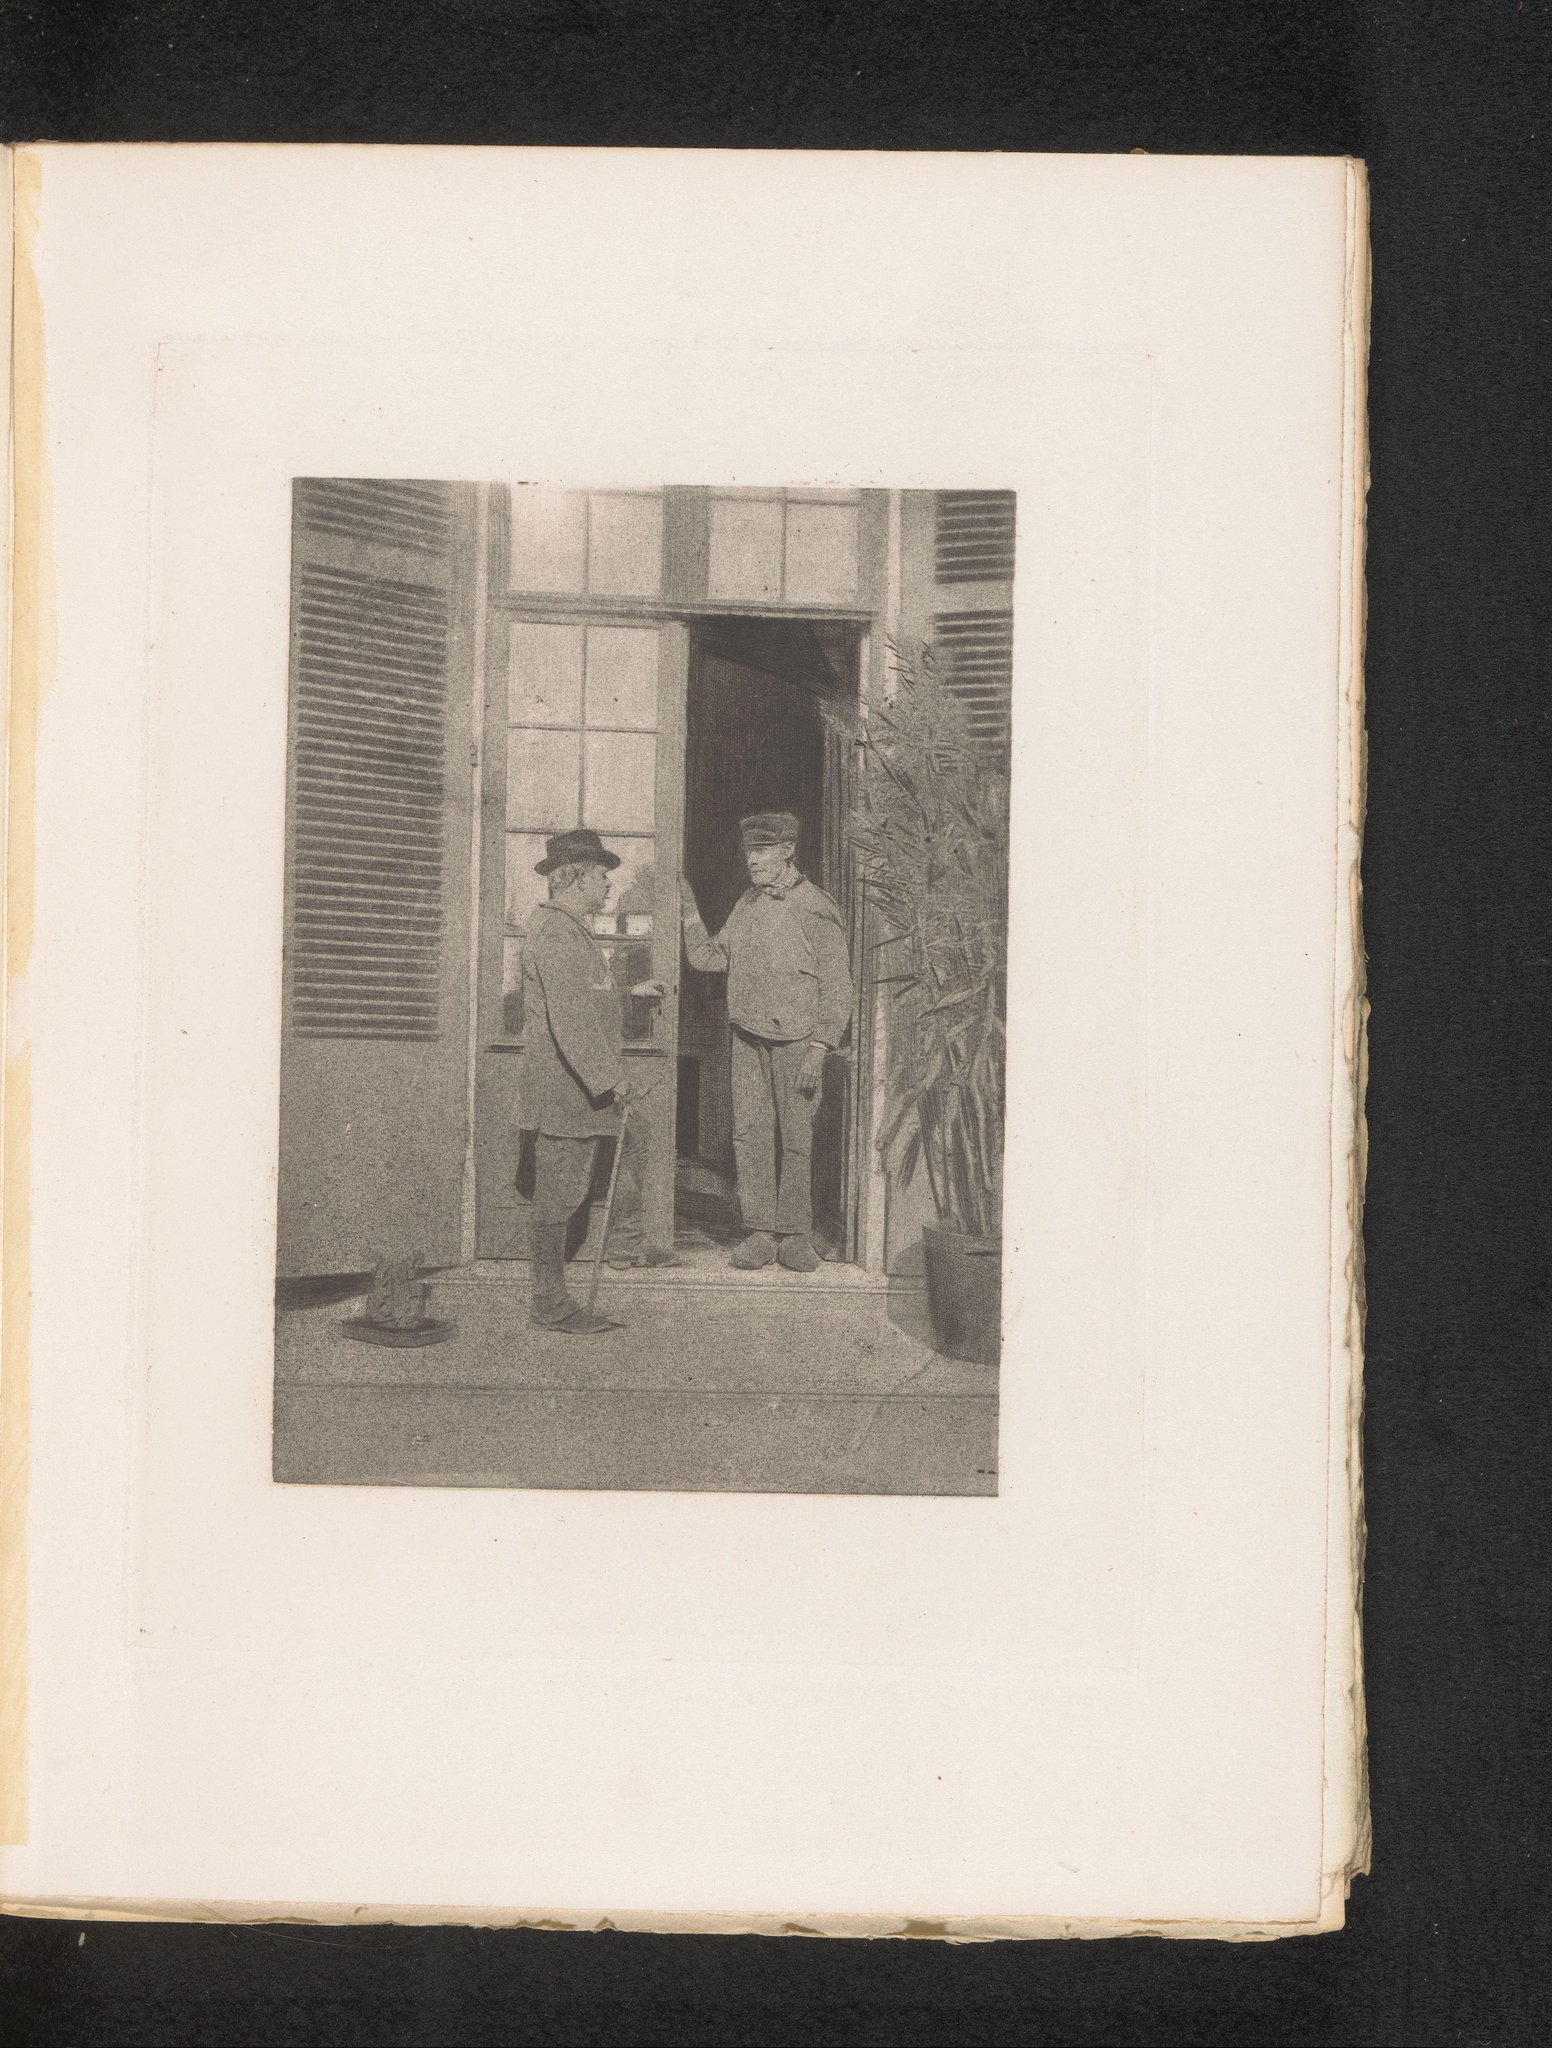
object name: photomechanical print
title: Reproductie van een gezicht op twee onbekende mannen waarvan één in de deuropening staat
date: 1879-1884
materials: paper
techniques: photoaquatint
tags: open door, painting, drawing and the graphic arts